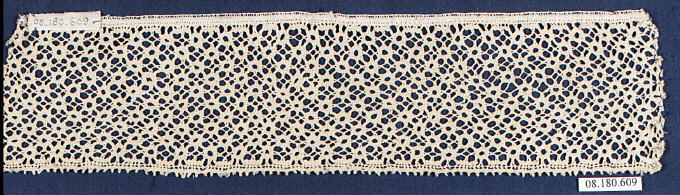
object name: fragment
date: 1701-1800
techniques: lace